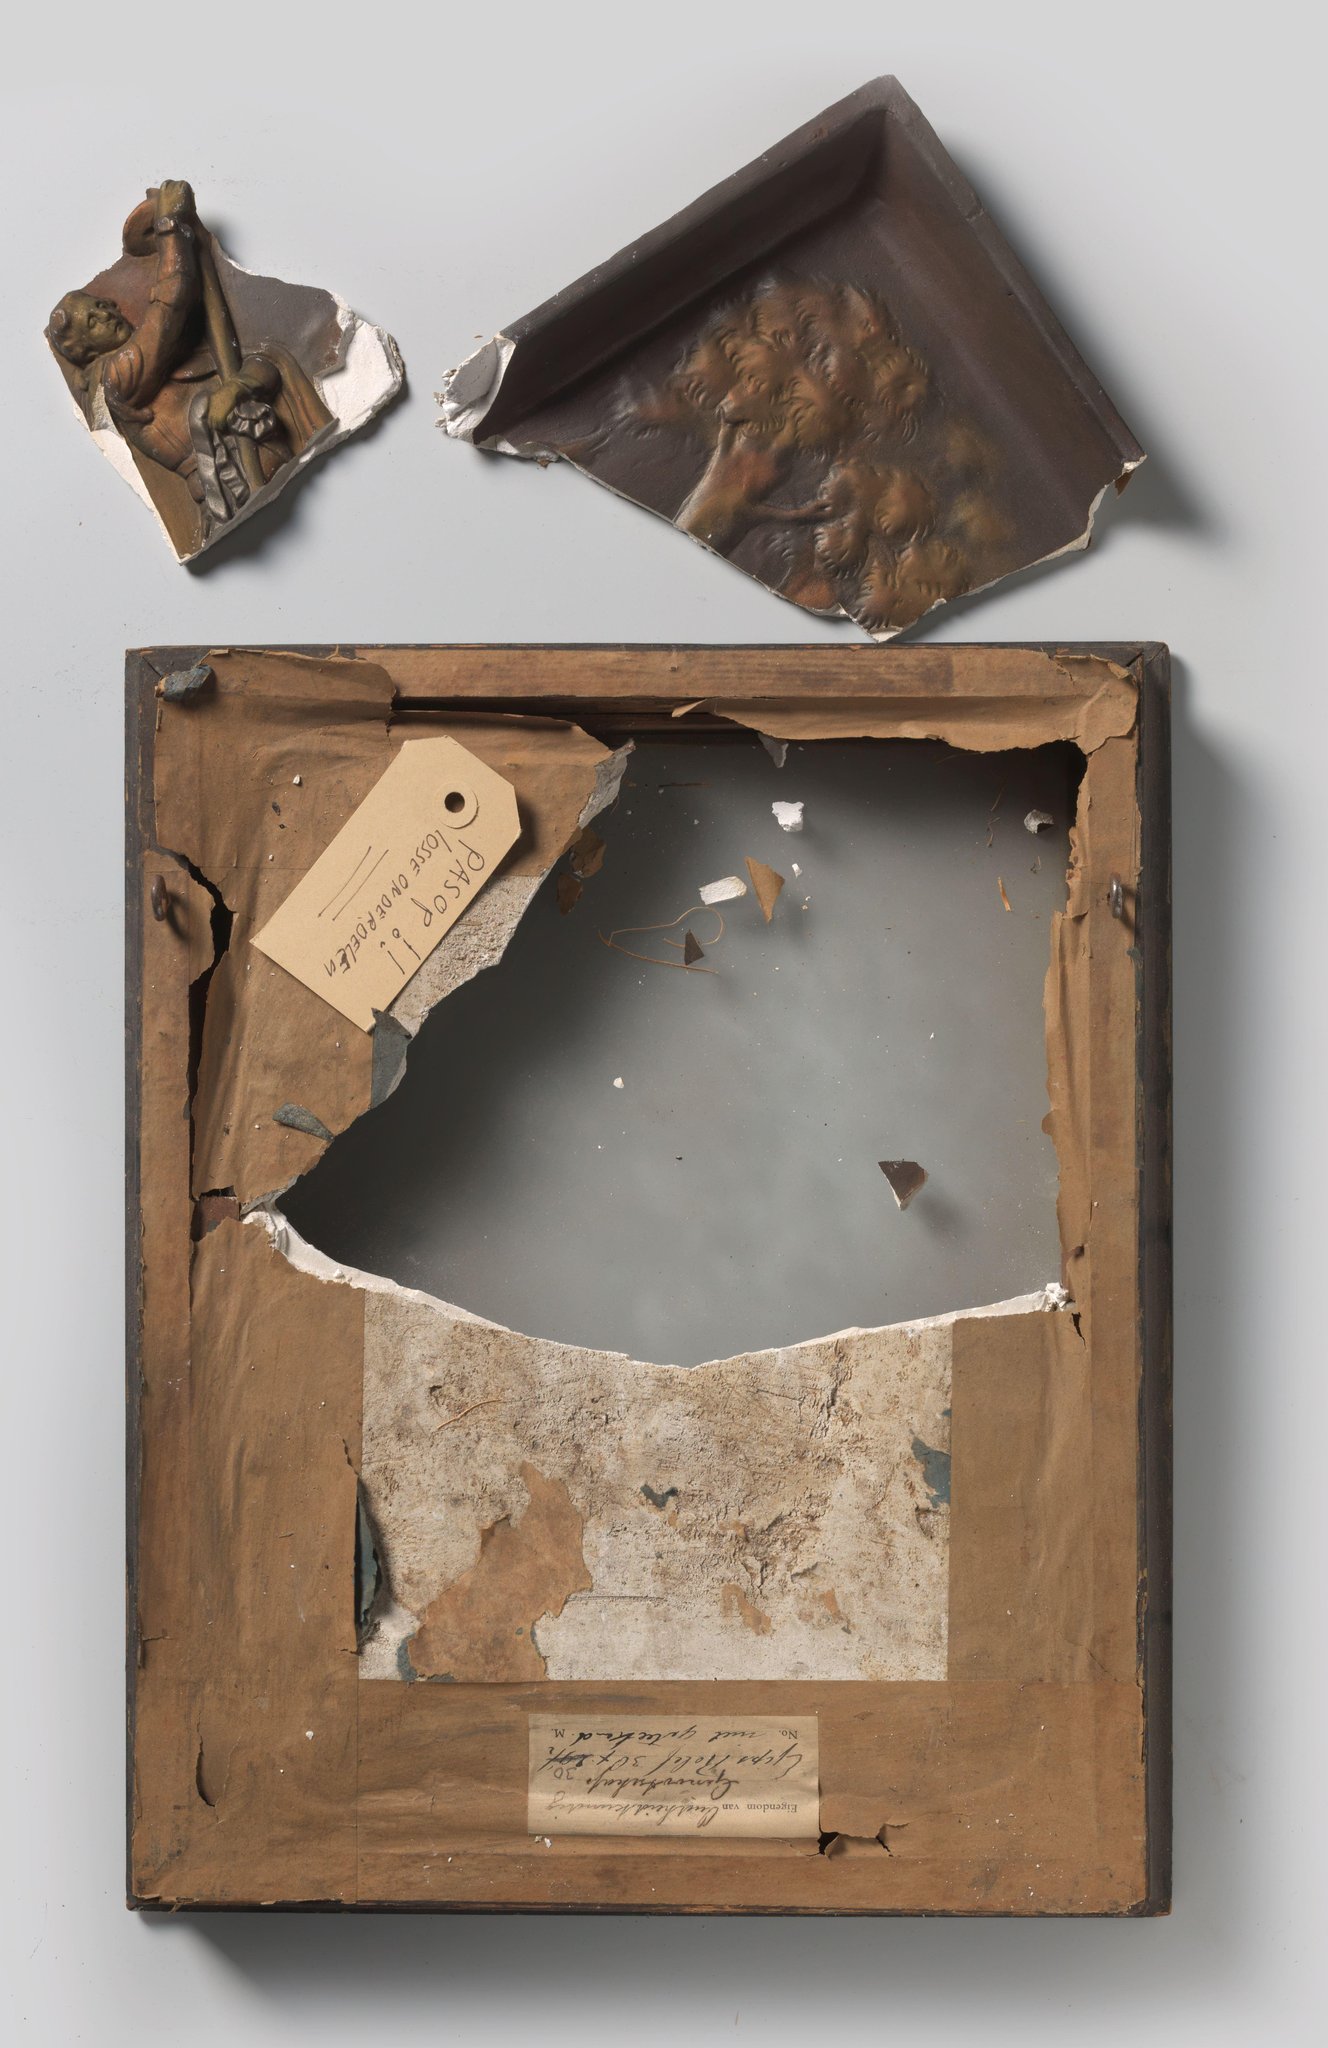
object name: relief sculpture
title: Reliëf van gekleurd gips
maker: Anonymous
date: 1700-1799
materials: gypsum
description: Een van de zes gekleurde gipsreliëfs achtger glas in lijst, voorstellende de vrijheid enz. met Prins Willem I tot Prins Willem V.